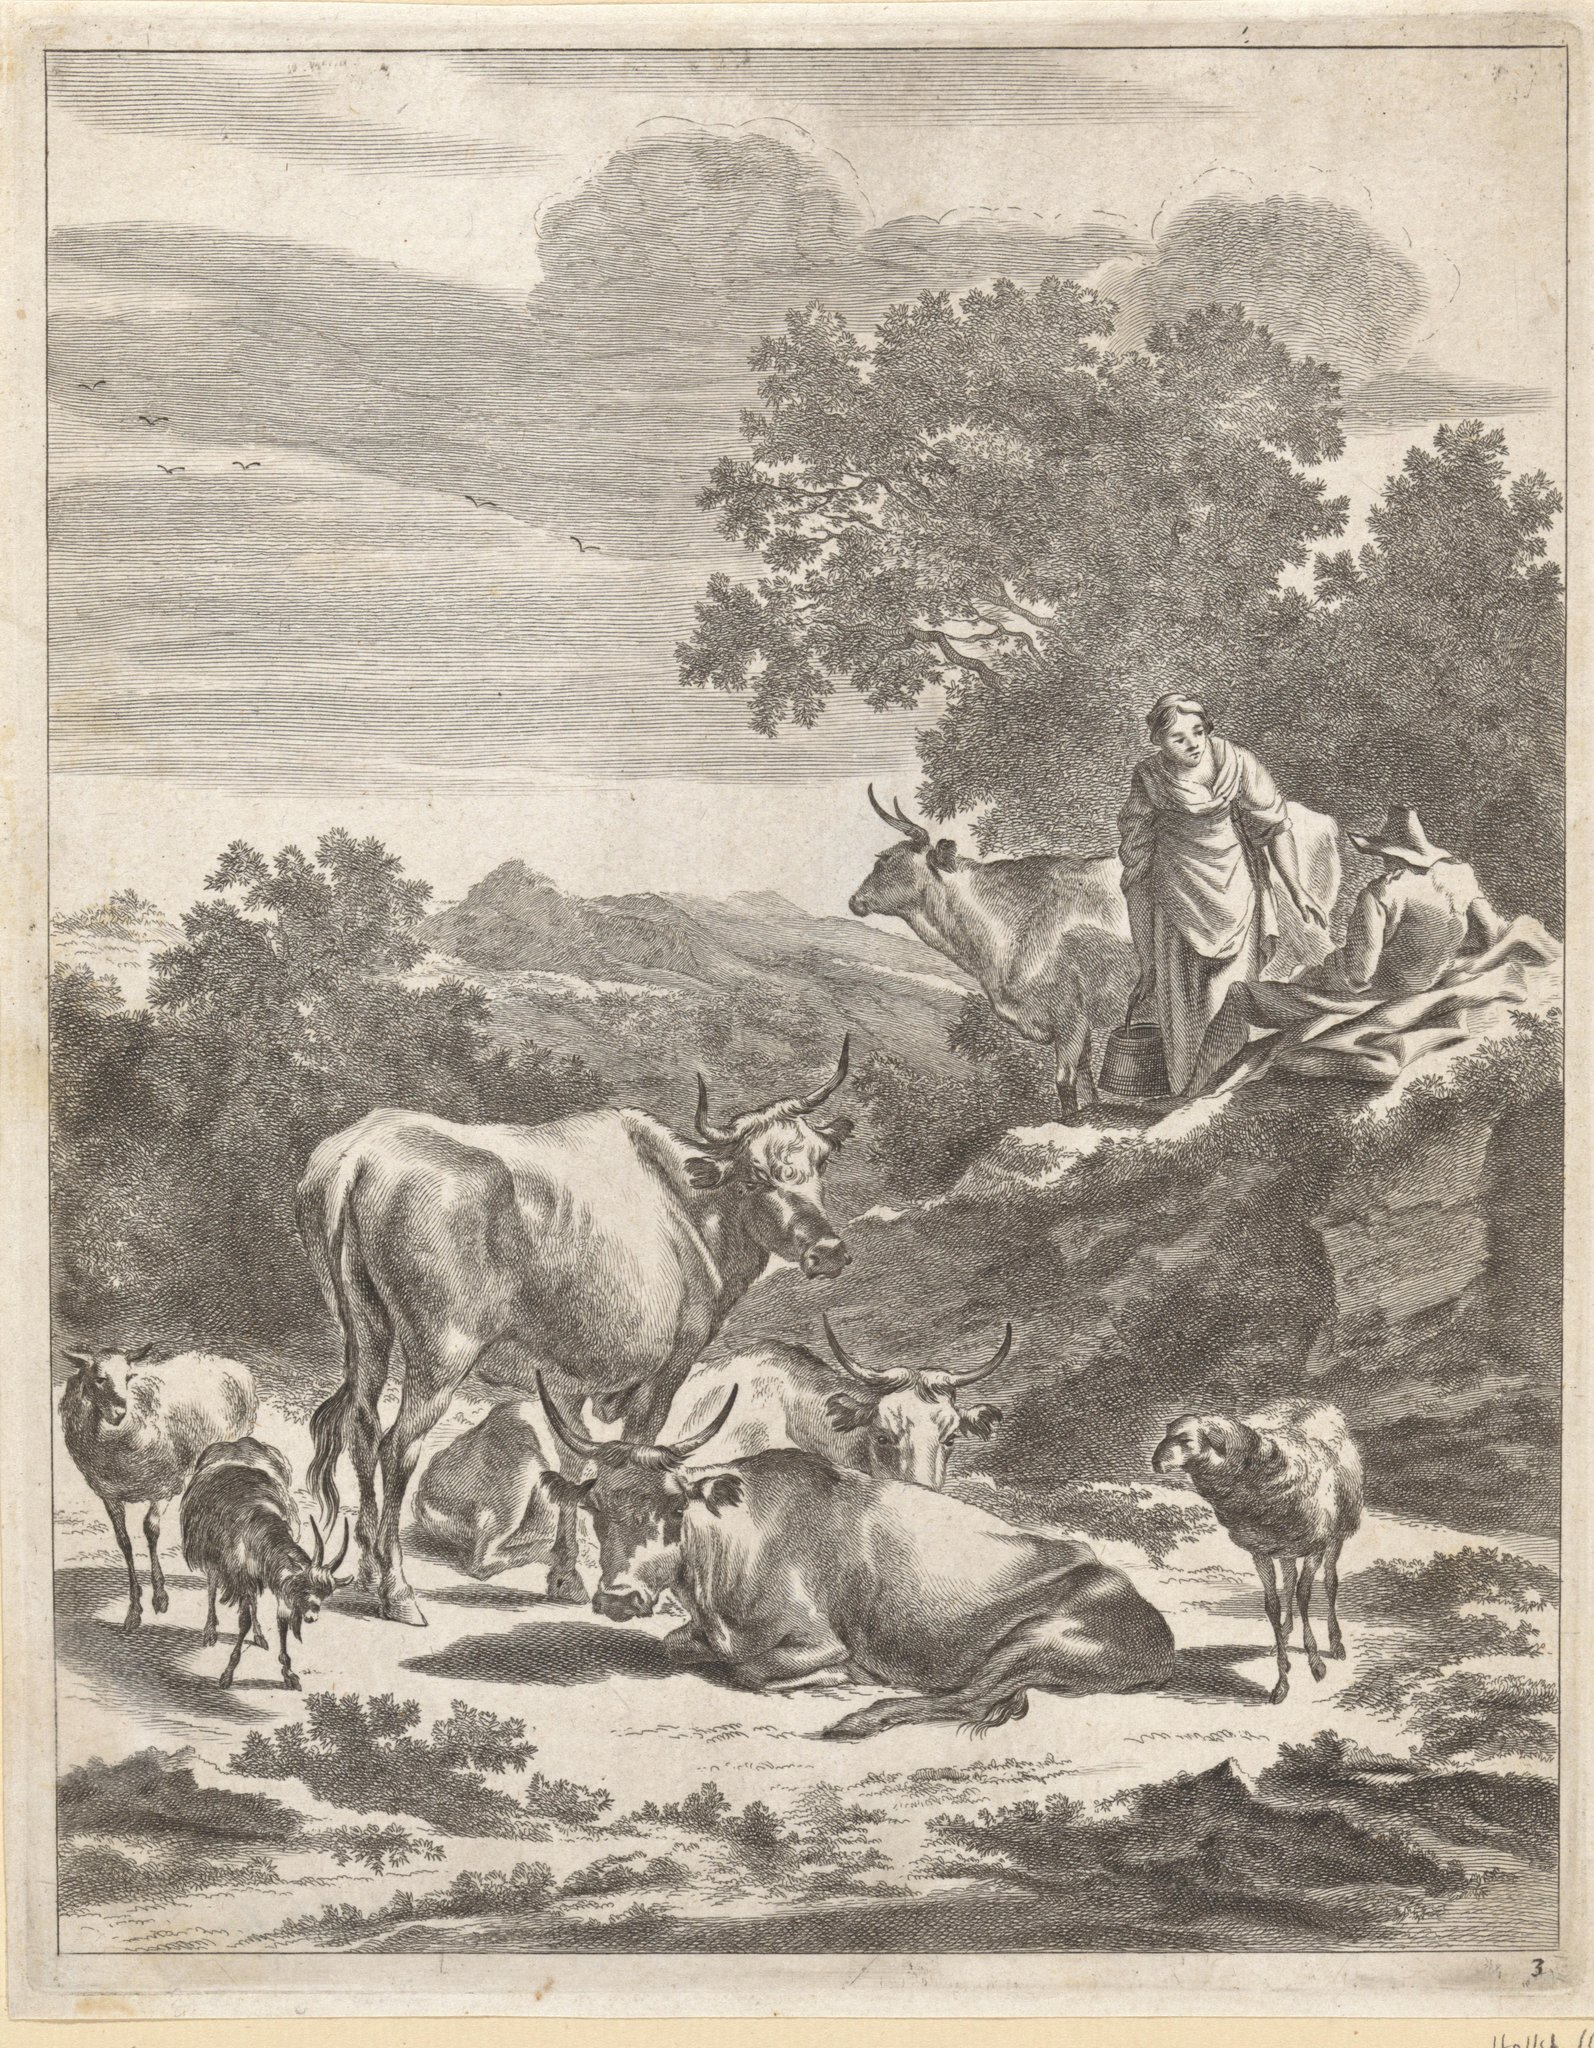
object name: print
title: Pastorale landschappen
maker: jan de visscher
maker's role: print maker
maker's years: 1633-1712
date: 1650-1701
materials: paper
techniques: engraving, etching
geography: northern netherlands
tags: cow, herding, herdsman, herdswoman, shepherd, shepherdess, cowherd, etc.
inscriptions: collector's mark: Lugt 240, collector's mark: Lugt 2228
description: Landschap met een herder en een herderin met een emmer tussen de koeien en schapen. De herder en herderin lijken een gesprek te voeren.